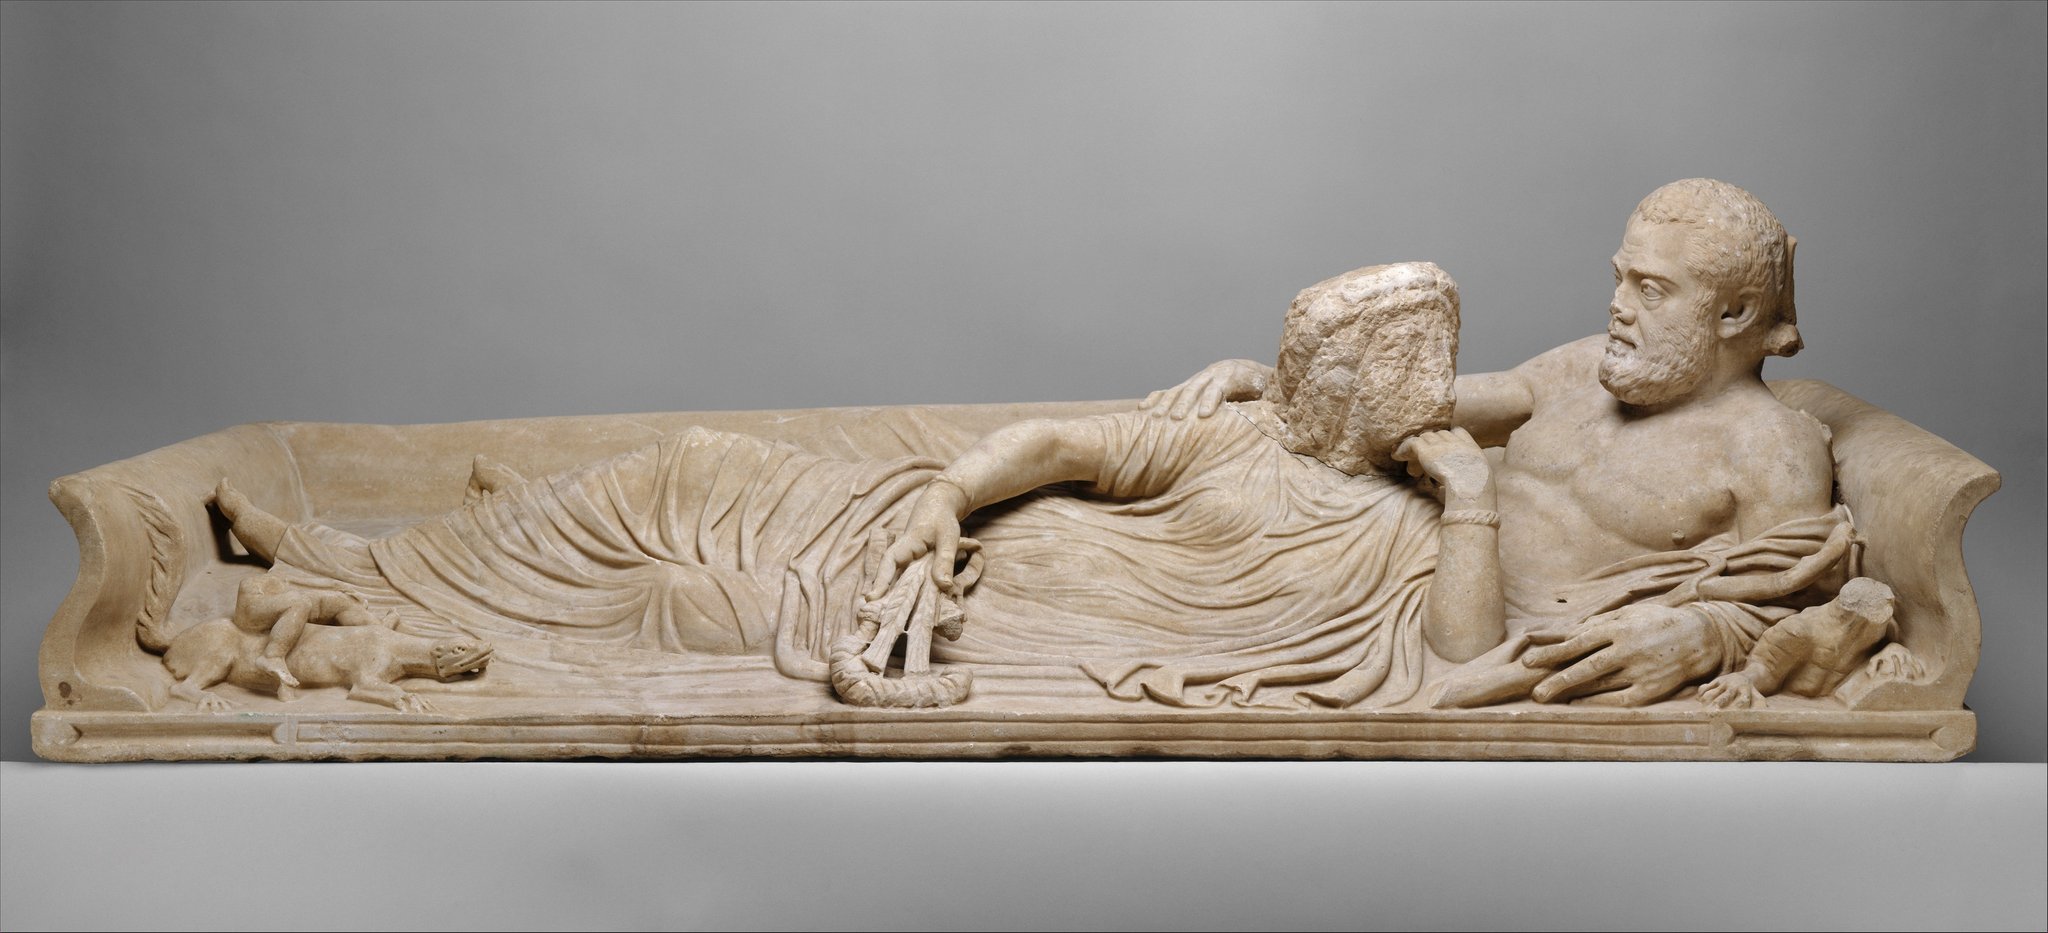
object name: sarcophagus lid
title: Marble sarcophagus lid with reclining couple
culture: roman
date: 220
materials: marble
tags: animals,couples,men,women